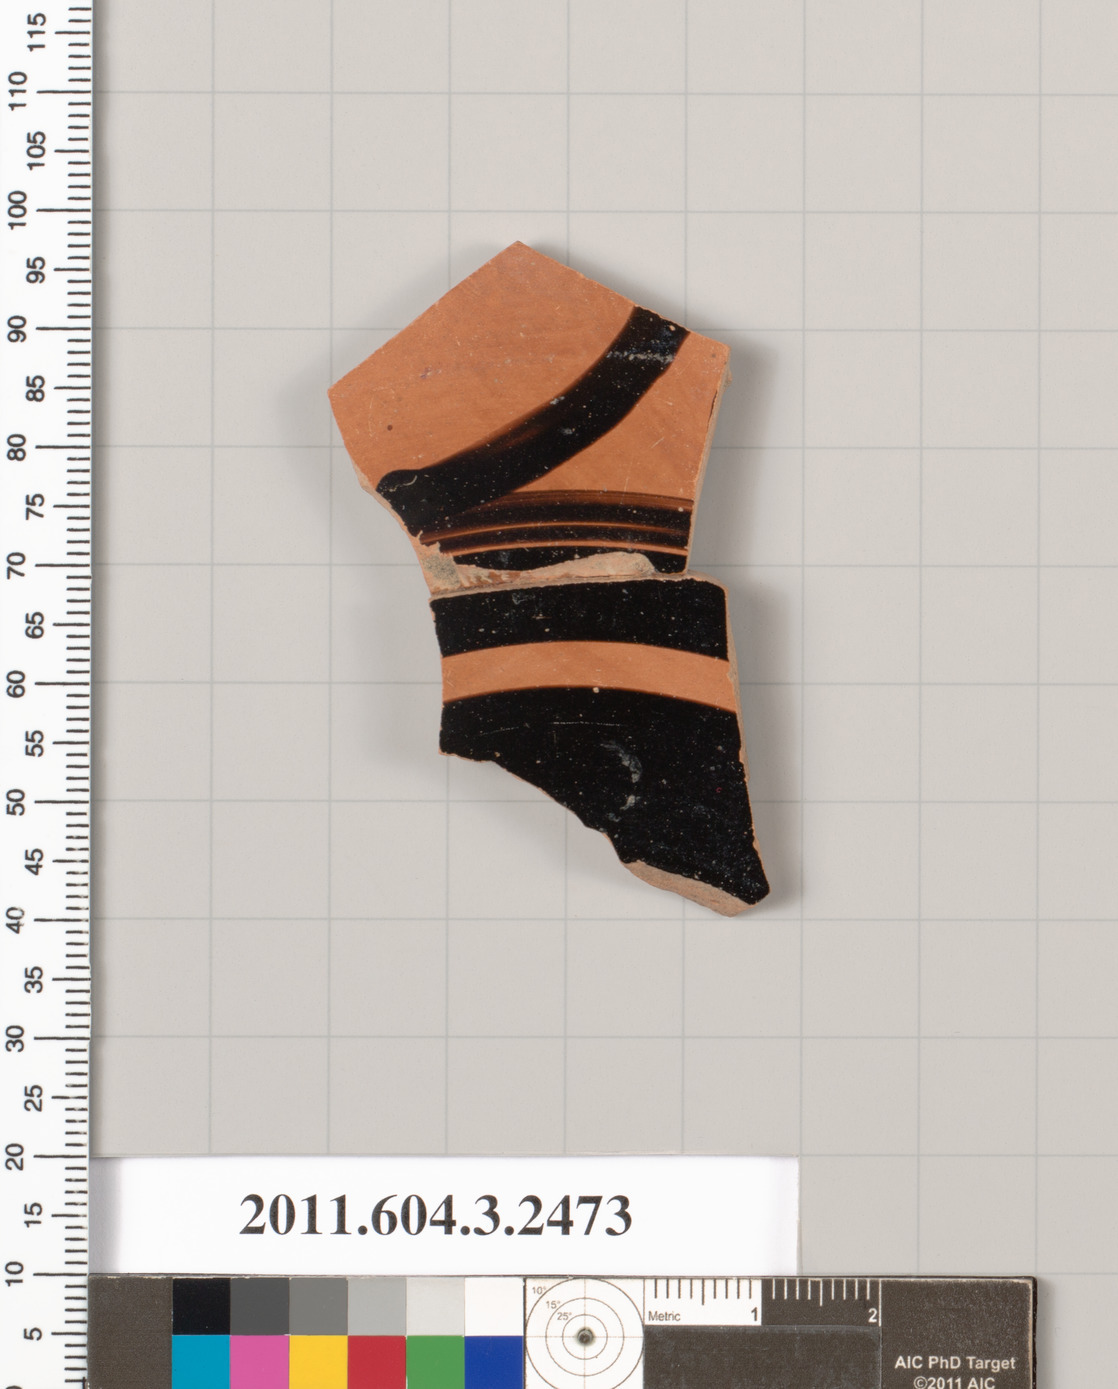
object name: kylix fragment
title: Terracotta fragment of a kylix: eye-cup (drinking cup)?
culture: greek, attic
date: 520-510 BCE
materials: terracotta